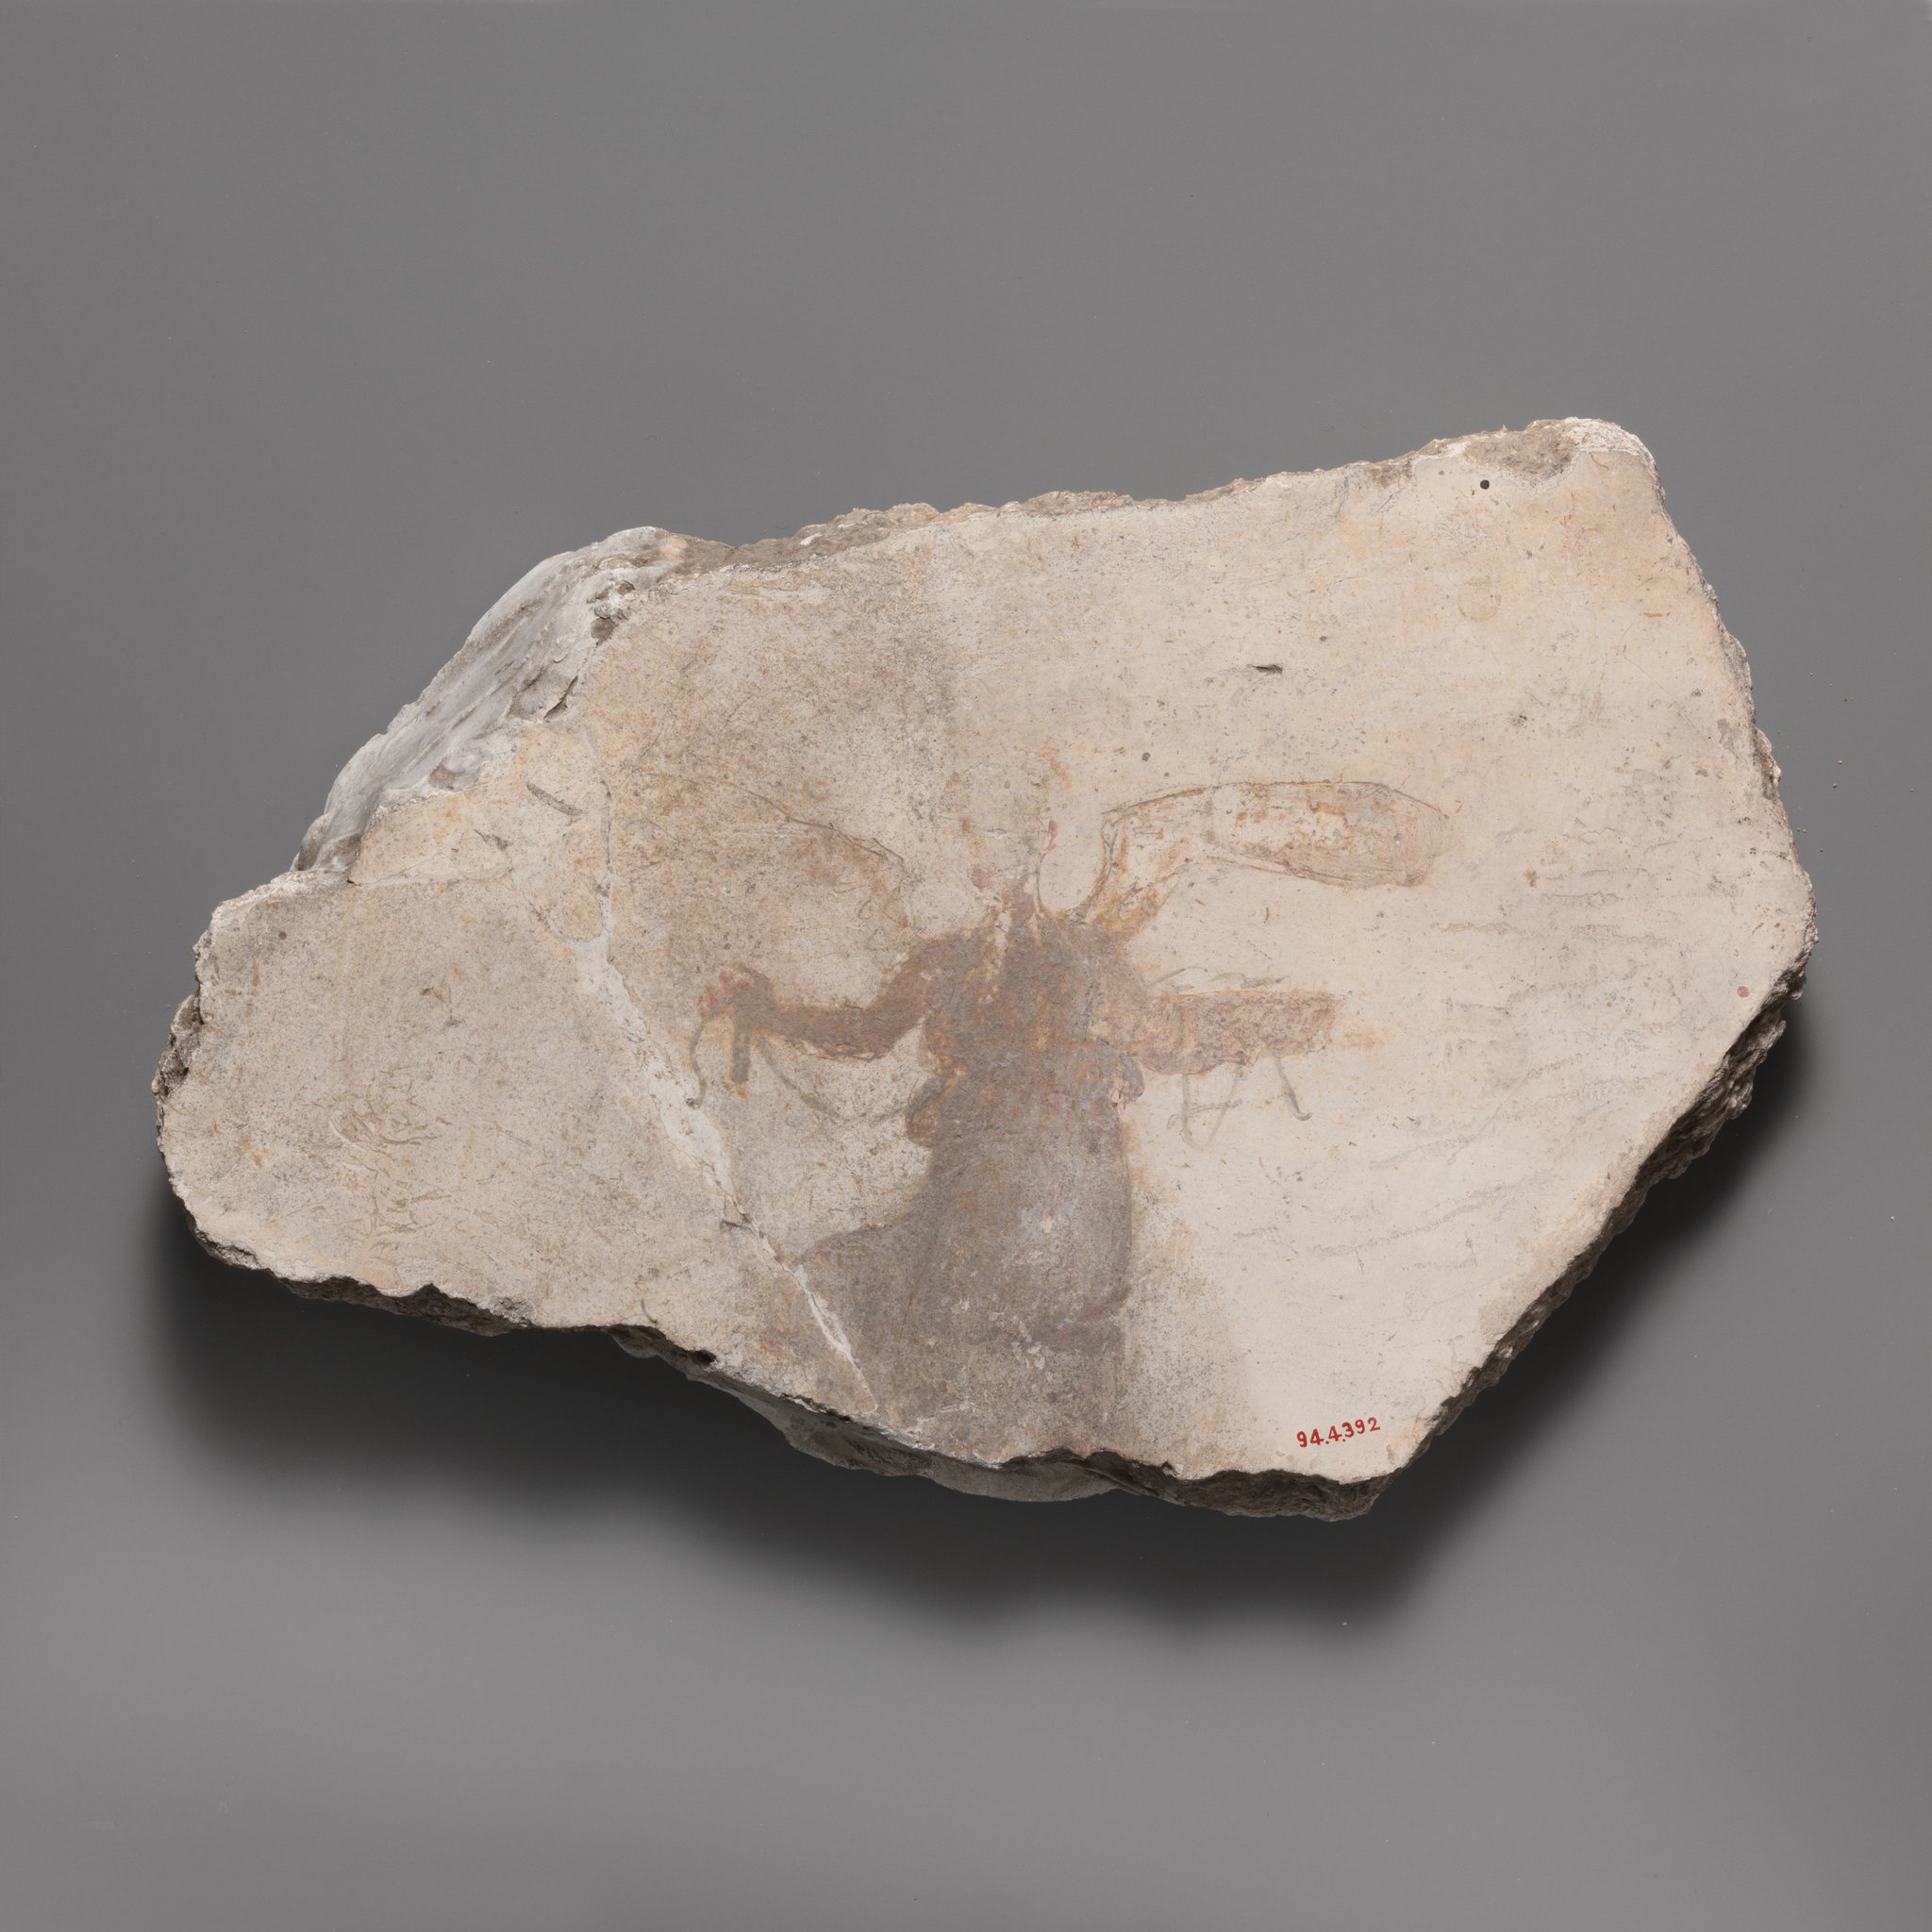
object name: wall painting fragment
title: Wall painting fragment with winged figure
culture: roman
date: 14-68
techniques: fresco